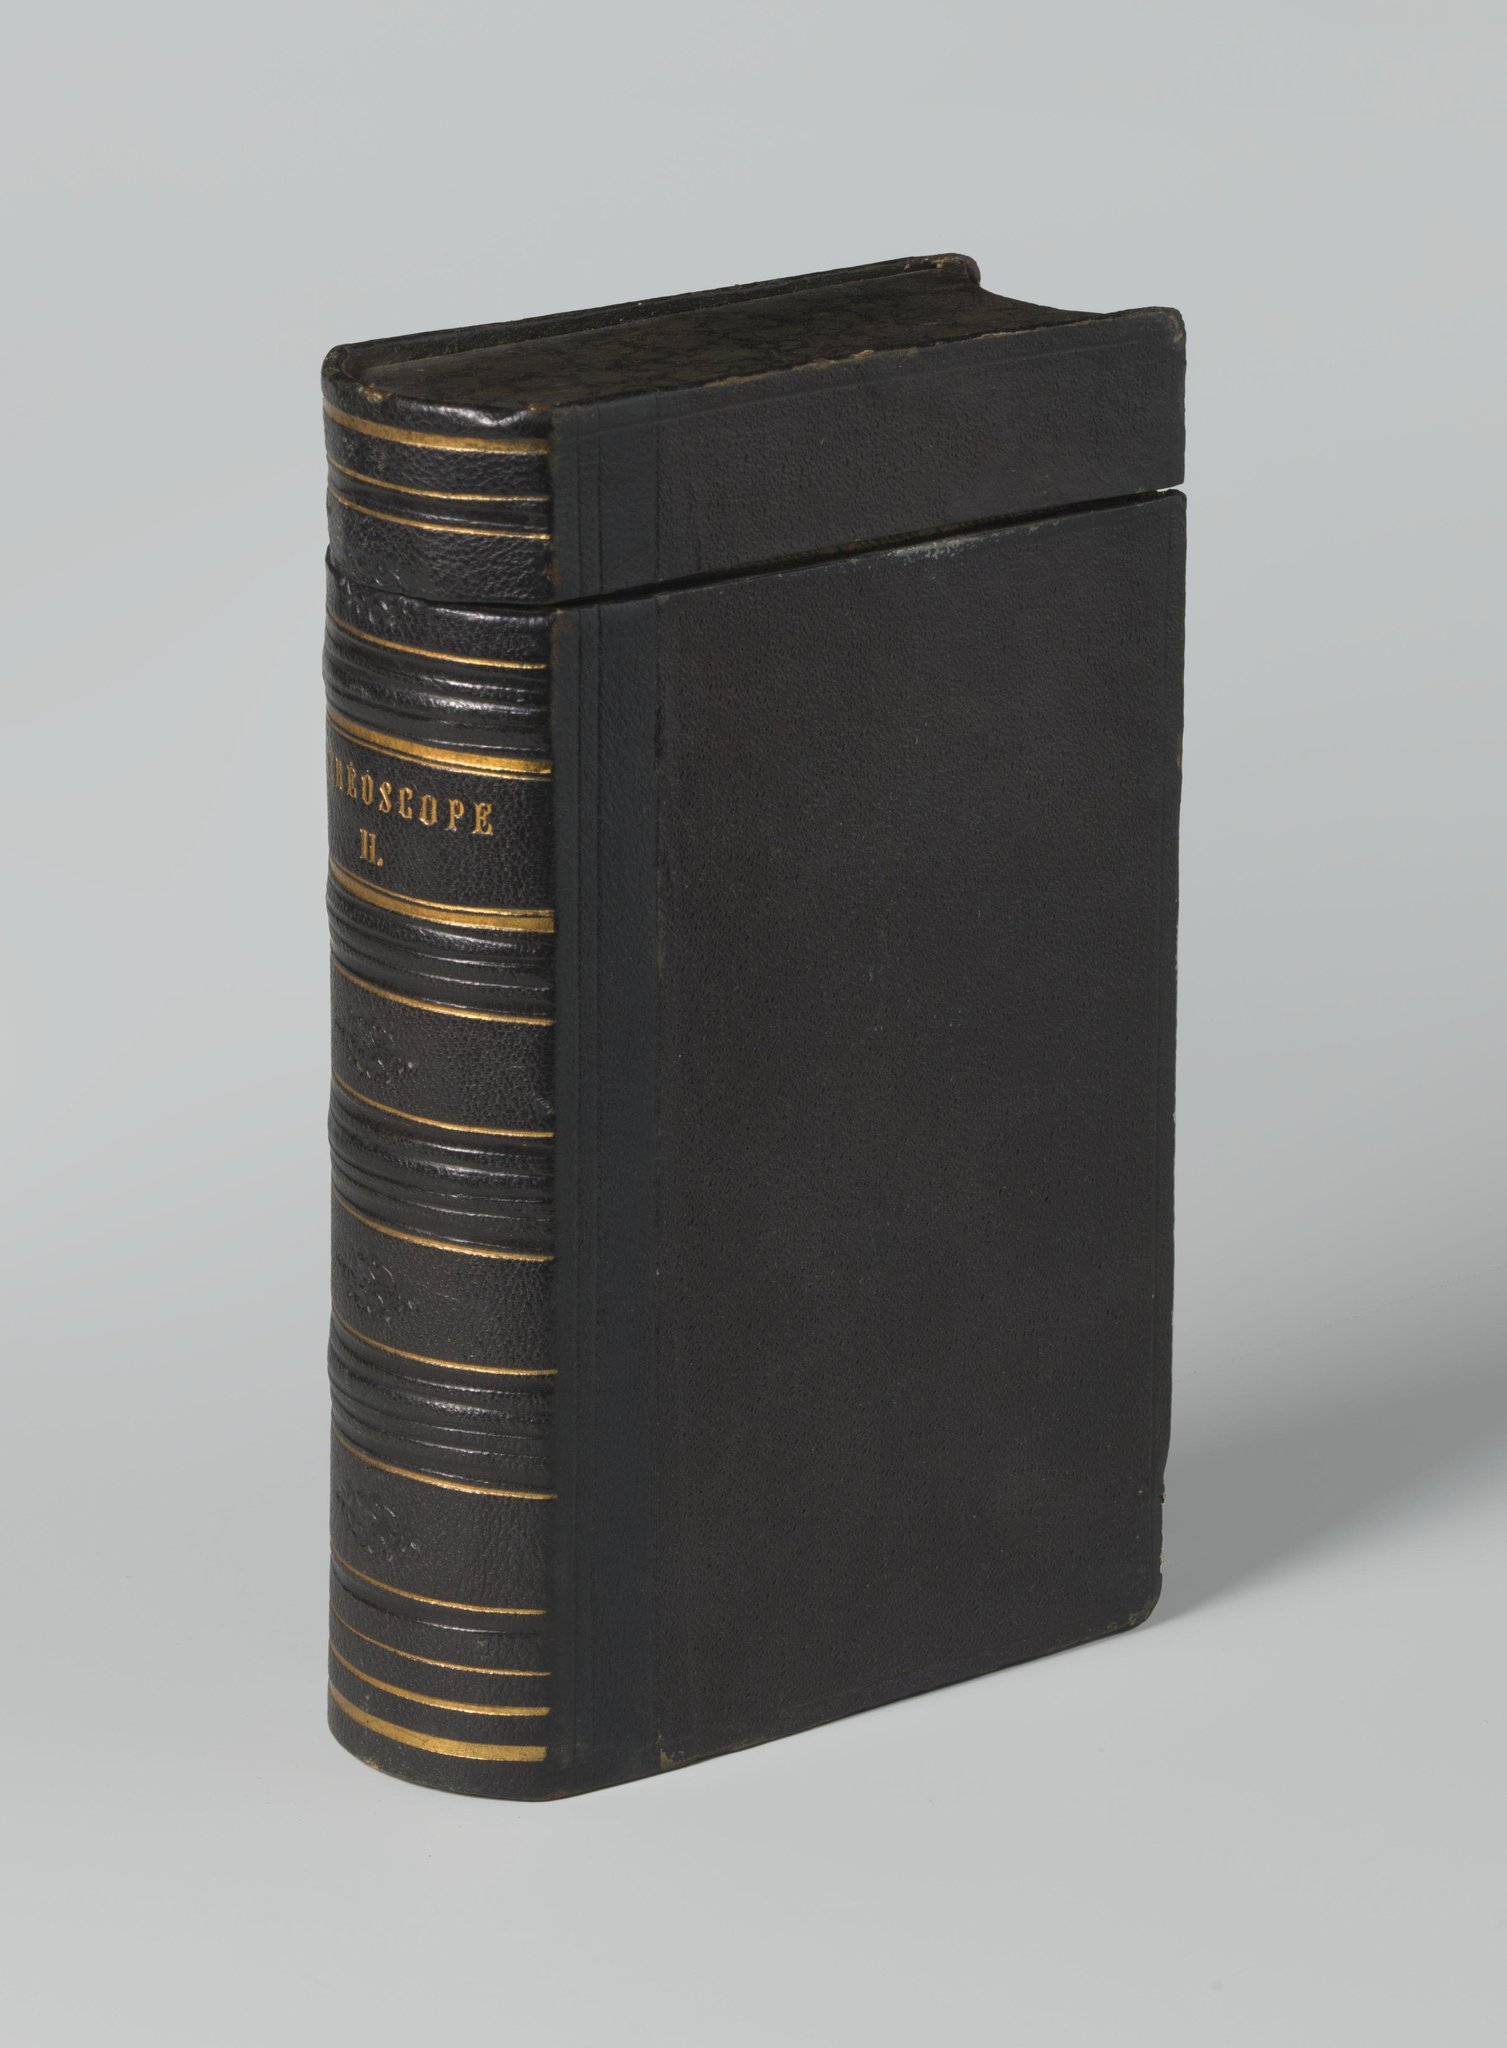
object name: box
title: Doos voor stereofoto's in de vorm van een boek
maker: Anonymous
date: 1860-1900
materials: cardboard, leather, paper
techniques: marbling, marbled paper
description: Doos in de vorm van boekband, voor het opbergen van stereofoto's (leeg).